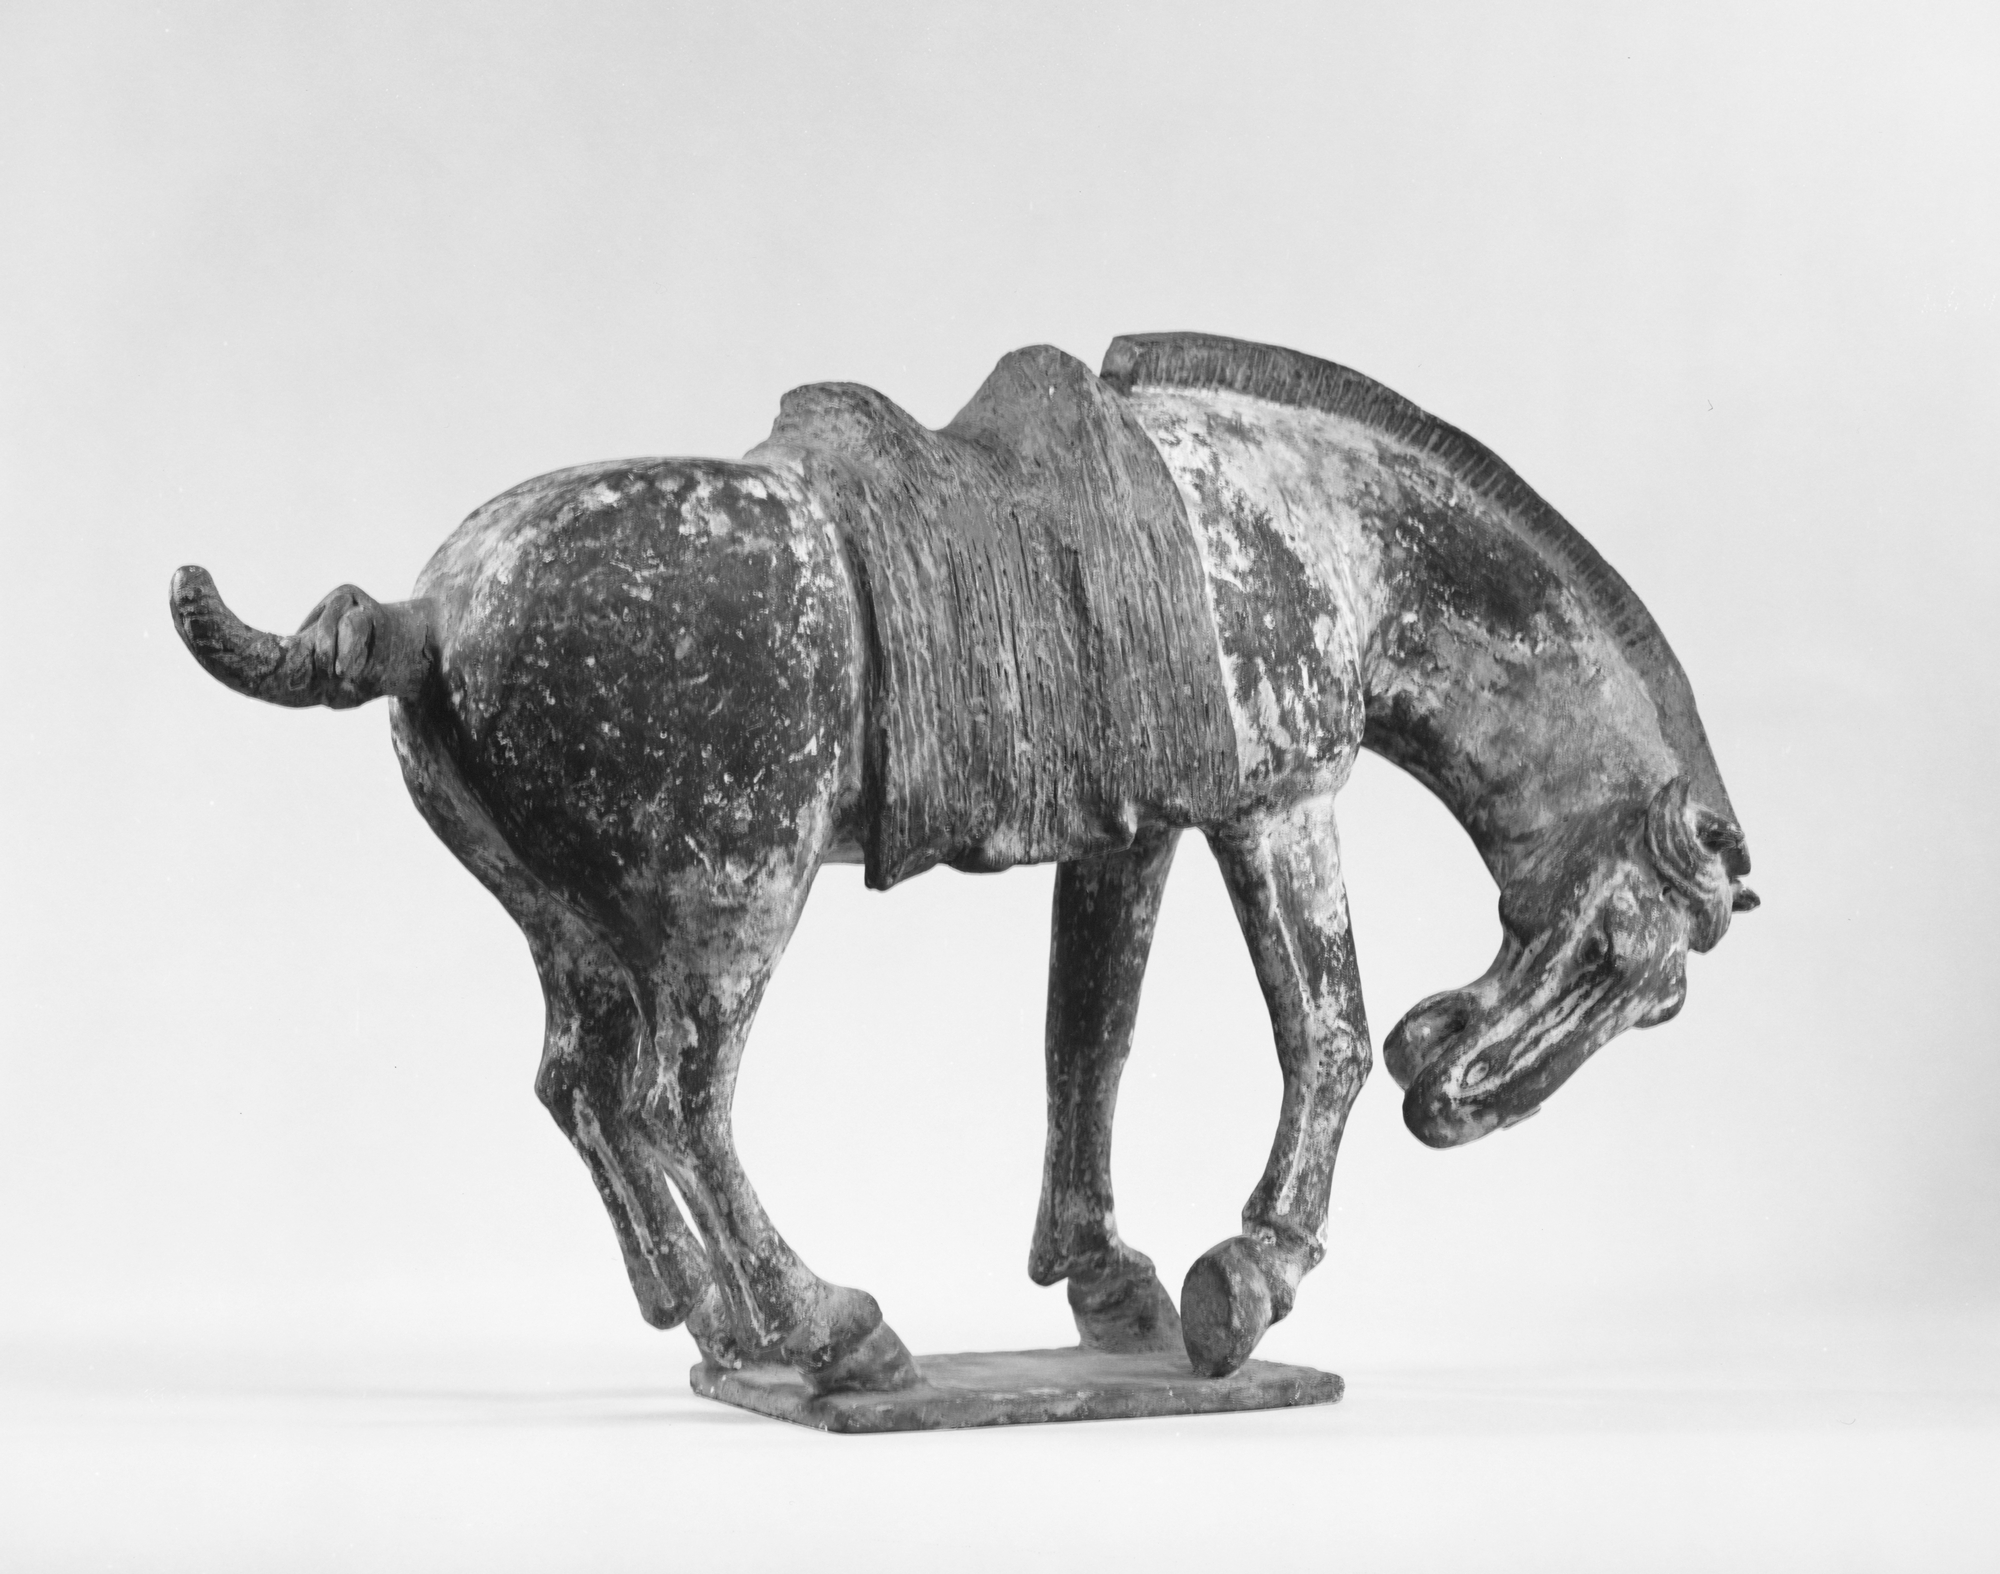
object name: figure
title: Horse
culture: chinese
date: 601-800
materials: earthenware, pigment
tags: horses